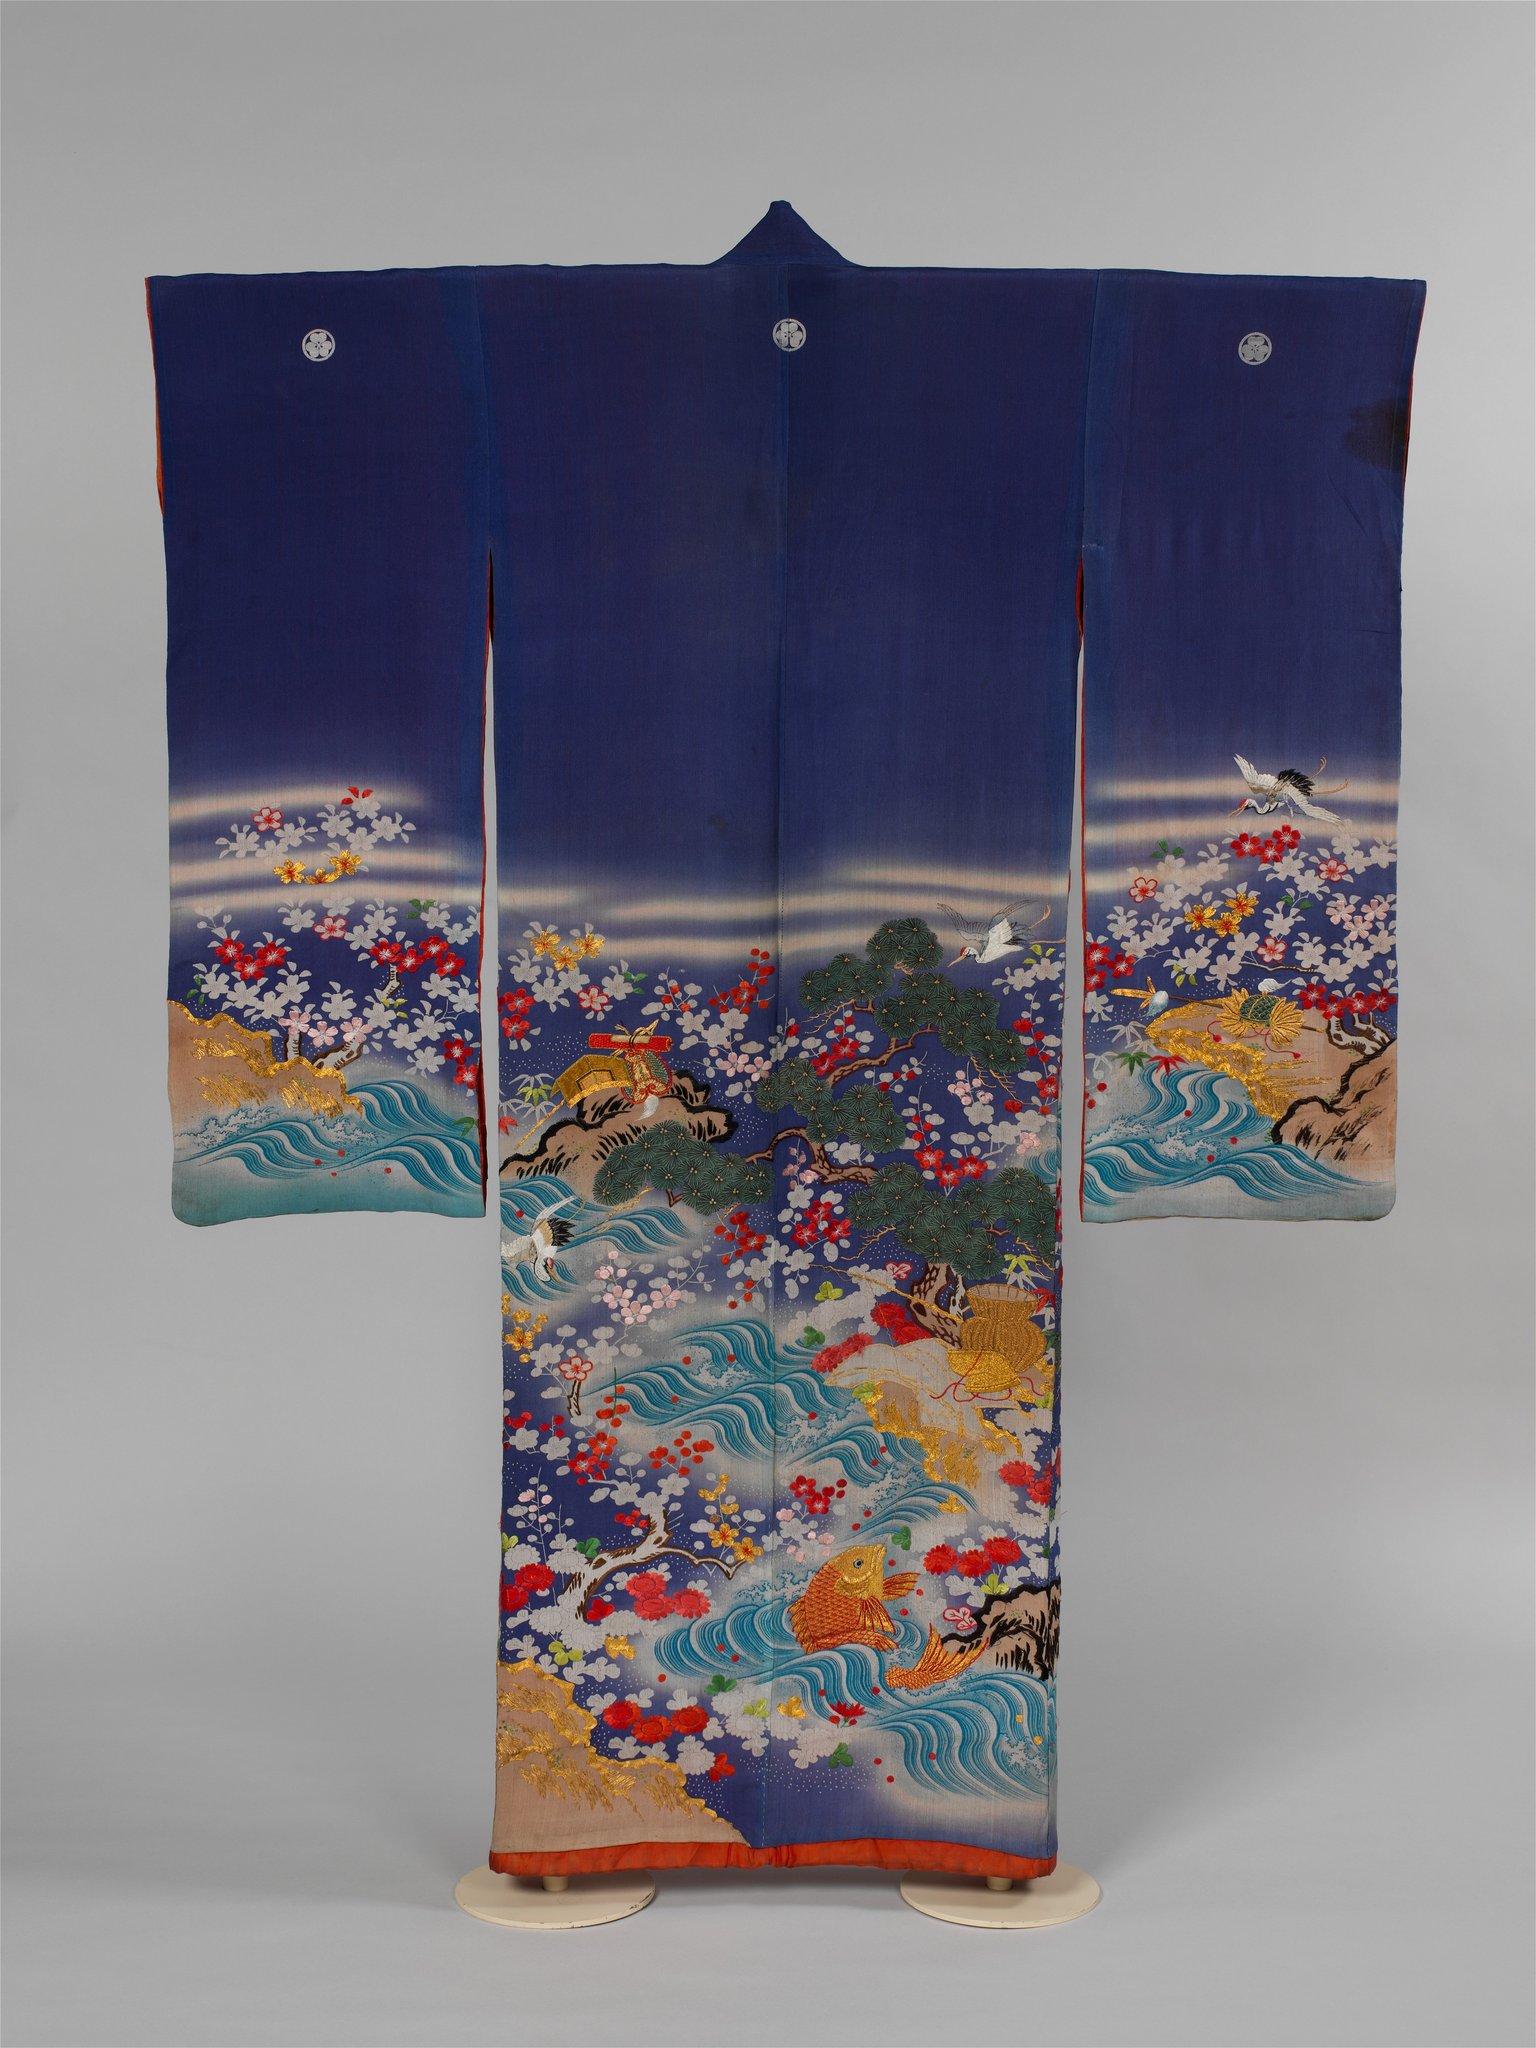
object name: kosode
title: Kosode with a Paragon of Filial Piety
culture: japanese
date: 1801-1900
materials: silk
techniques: dyeing, embroidery, painting, resist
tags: cranes,flowers